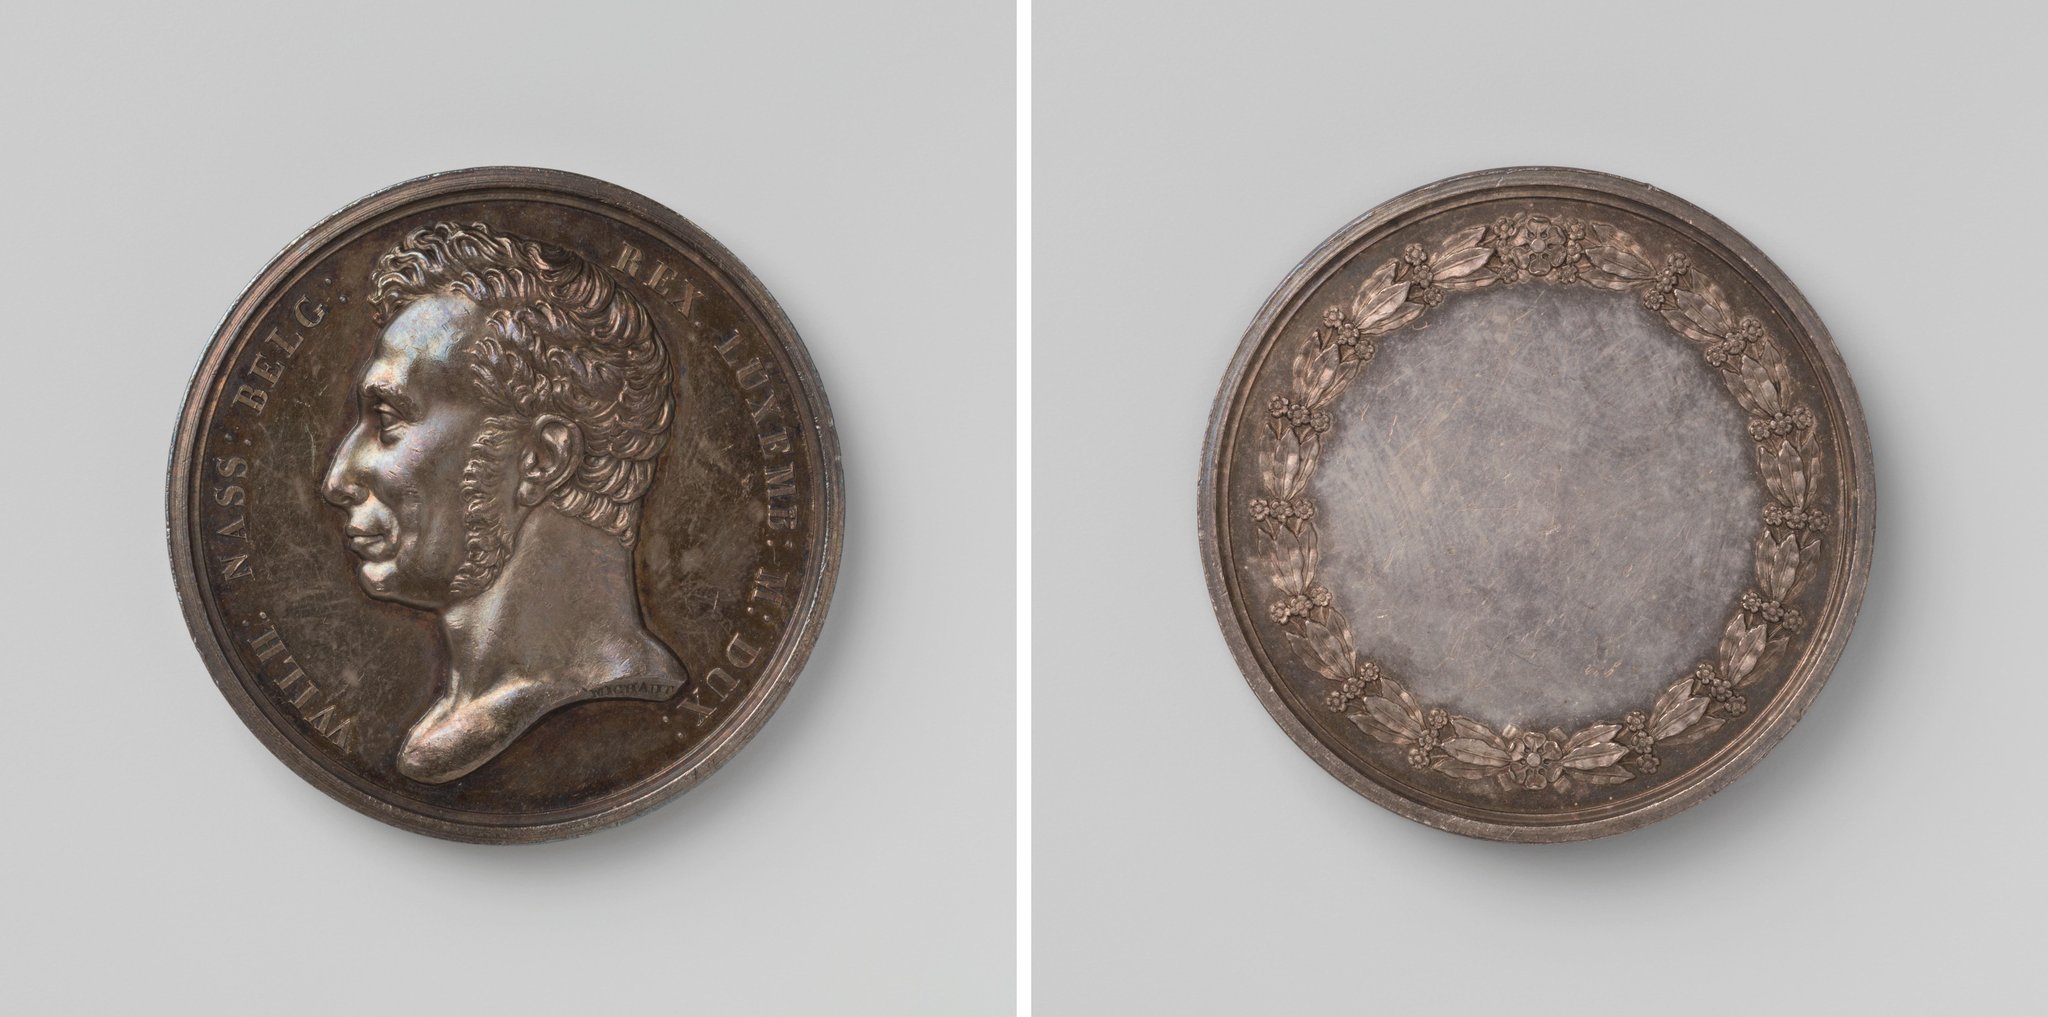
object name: honorary medal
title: Willem I, koning der Nederlanden, penning van de derde grootte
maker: auguste francois michaut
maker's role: sculptor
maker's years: 1786-1879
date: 1819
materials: silver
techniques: striking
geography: brussels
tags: the hague, berlin, william i of the netherlands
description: Zilveren penning. Voorzijde: borststuk man binnen omschrift. Keerzijde: blanco veld binnen myrtekrans